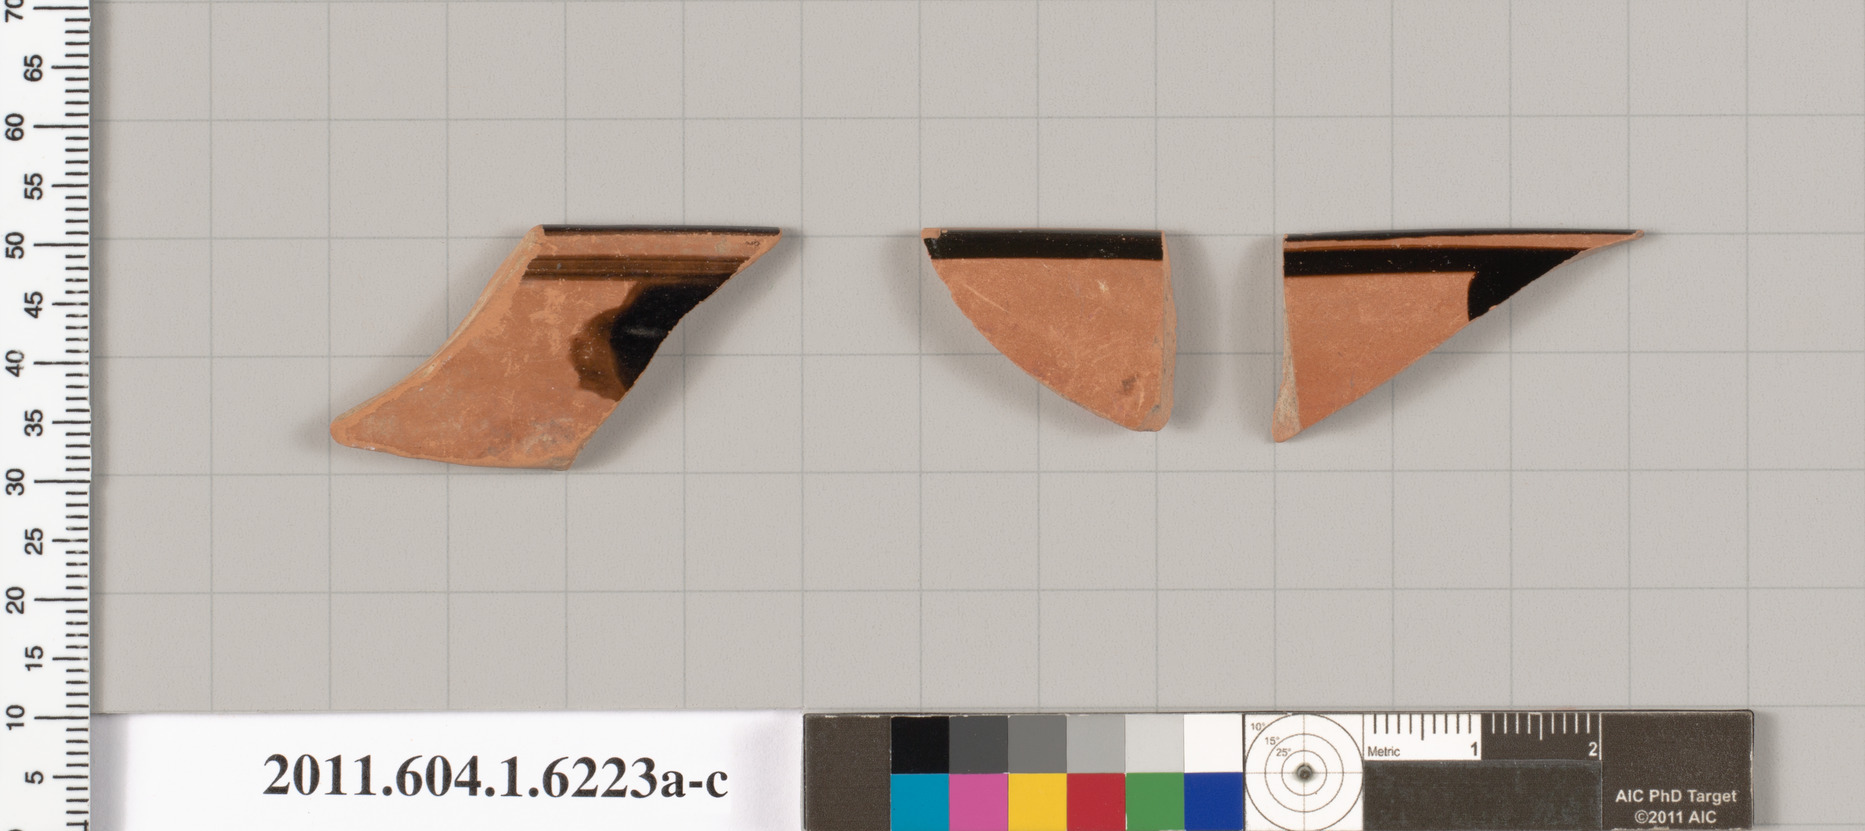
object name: kylix fragment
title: Terracotta rim fragments of kylikes (drinking cups)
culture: greek, attic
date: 510-500 BCE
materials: terracotta